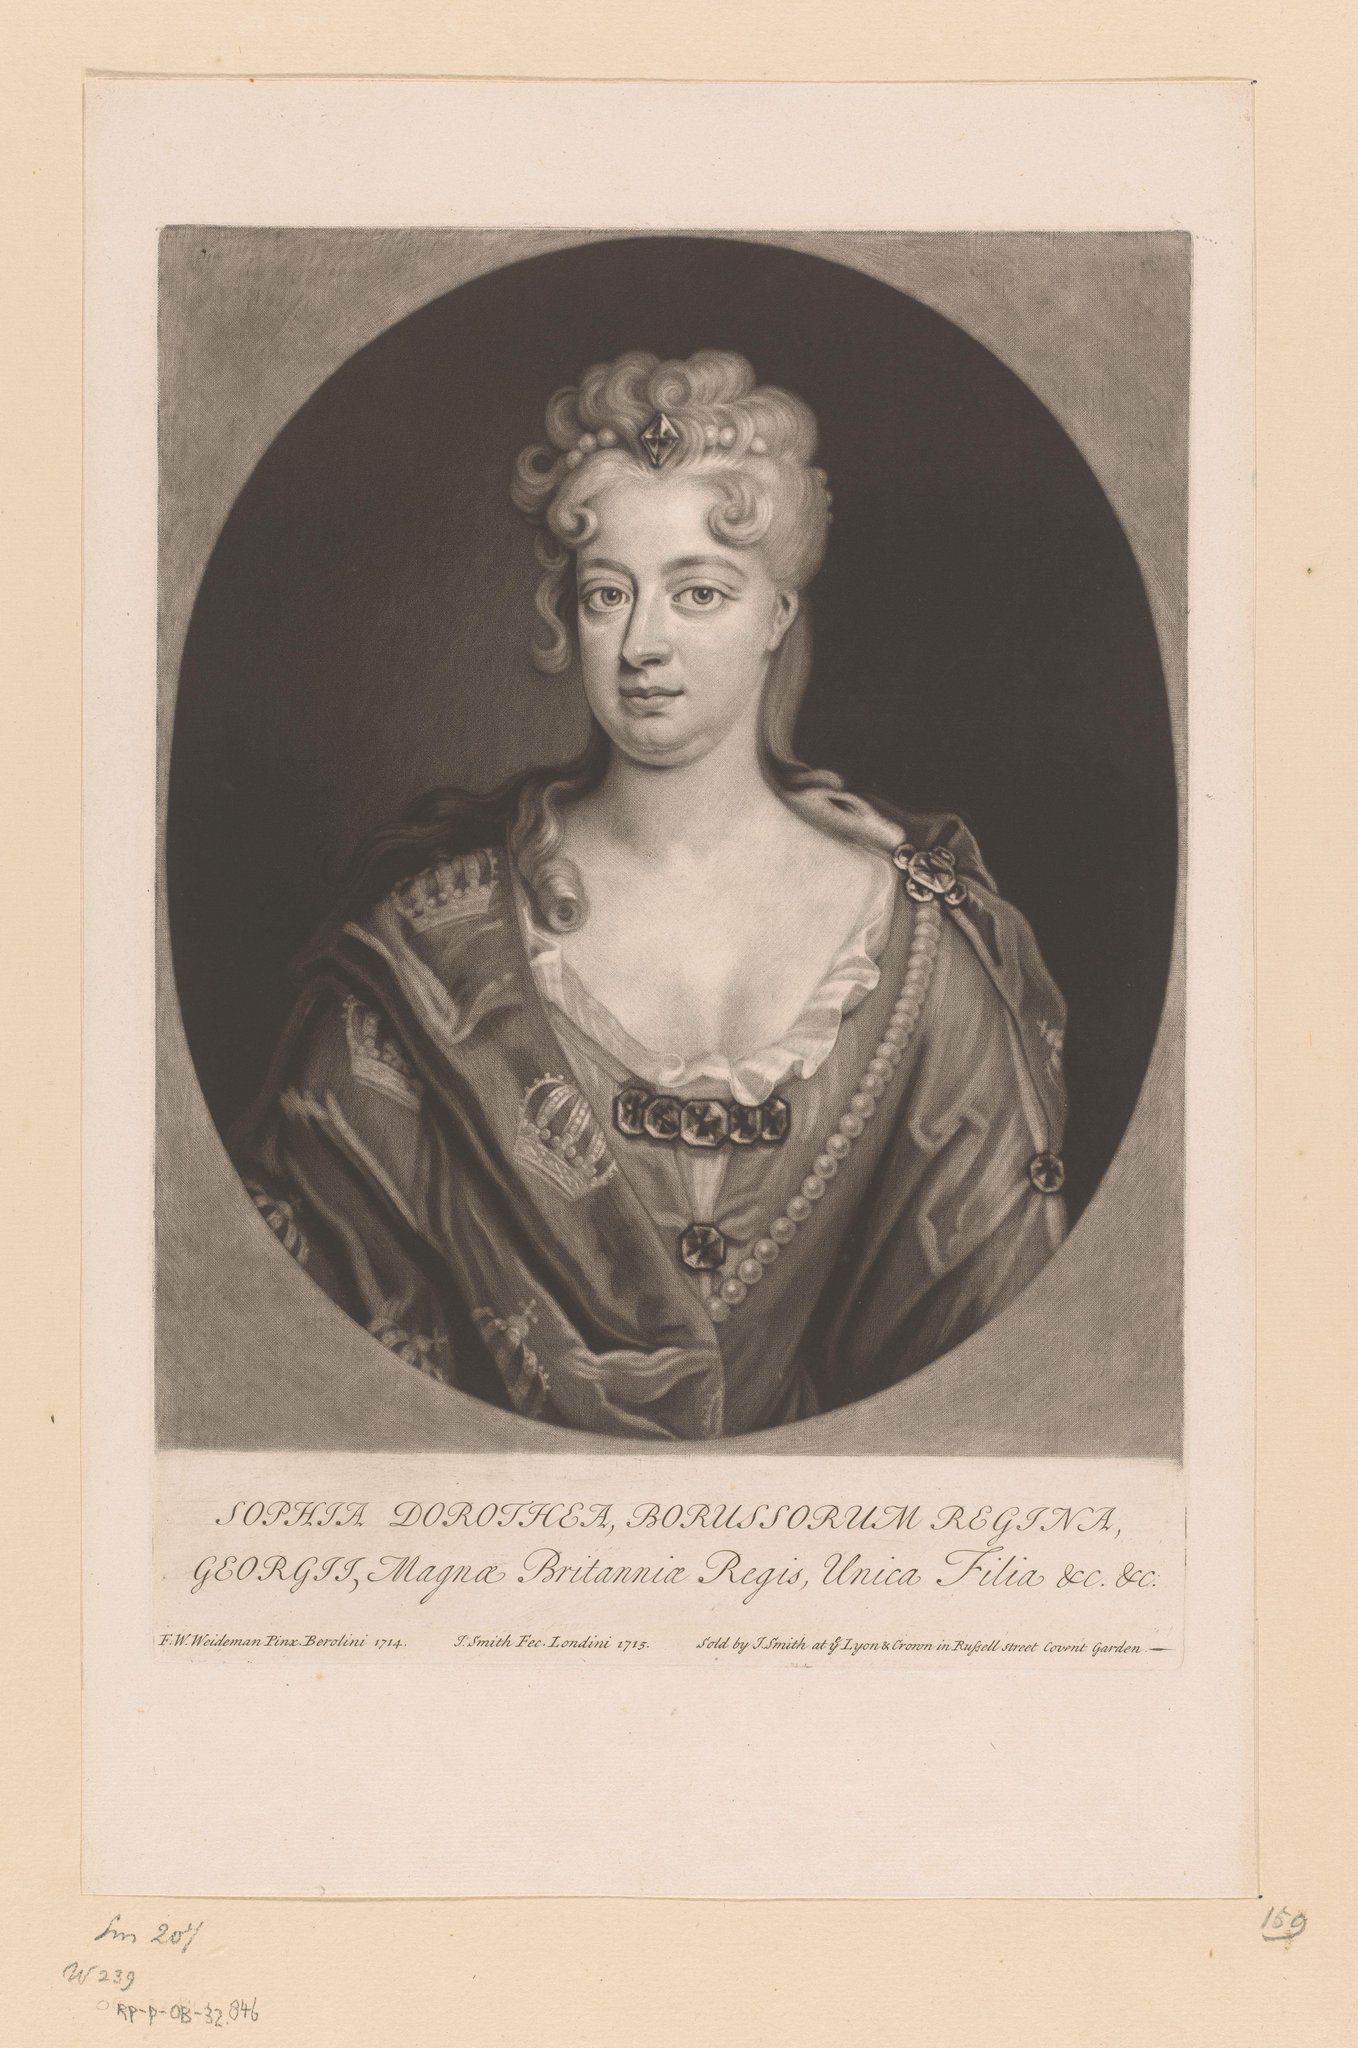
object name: print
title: Portret van Sophia Dorothea van Hannover, koningin van Pruisen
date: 1714-1715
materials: paper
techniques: mezzotint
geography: london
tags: berlin, historical persons, princess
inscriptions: collector's mark: Lugt 240